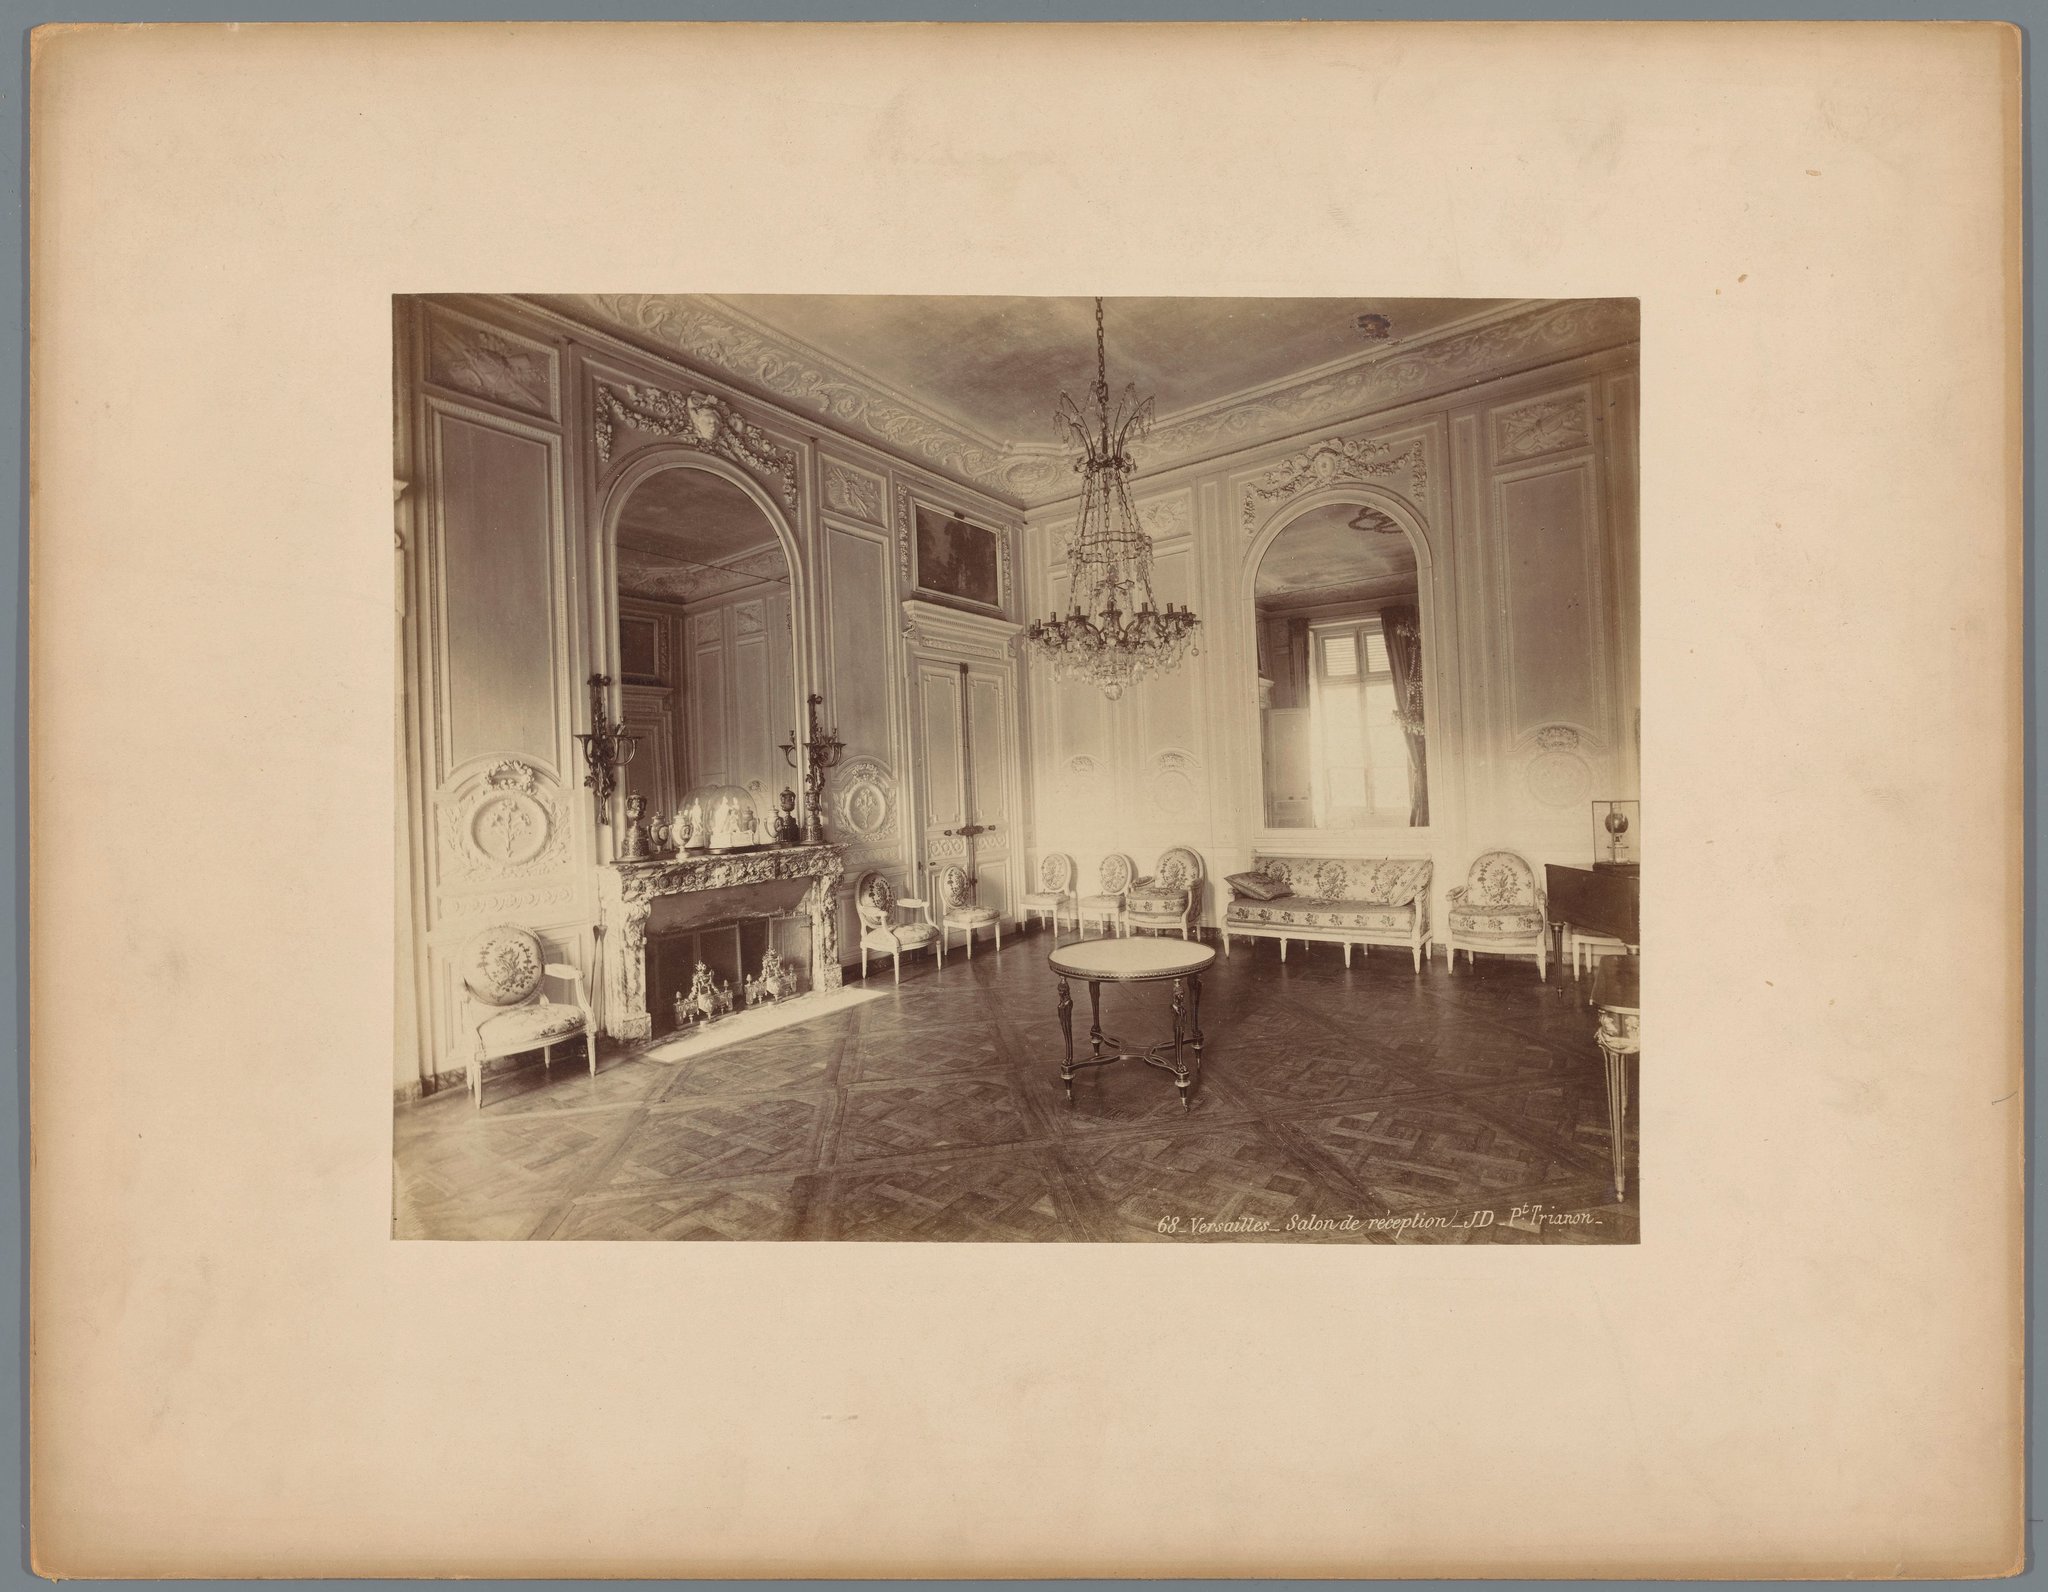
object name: photograph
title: Versailles - Salon de réception Pt. Trianon.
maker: Anonymous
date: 1875-1900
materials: cardboard, photographic support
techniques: albumen print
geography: petit trianon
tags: drawing-room, 'salon', mirror, interior ~ representation of a building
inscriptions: number: ‘68’, collector's mark: Lugt 3937, inscription: ‘J.D.’